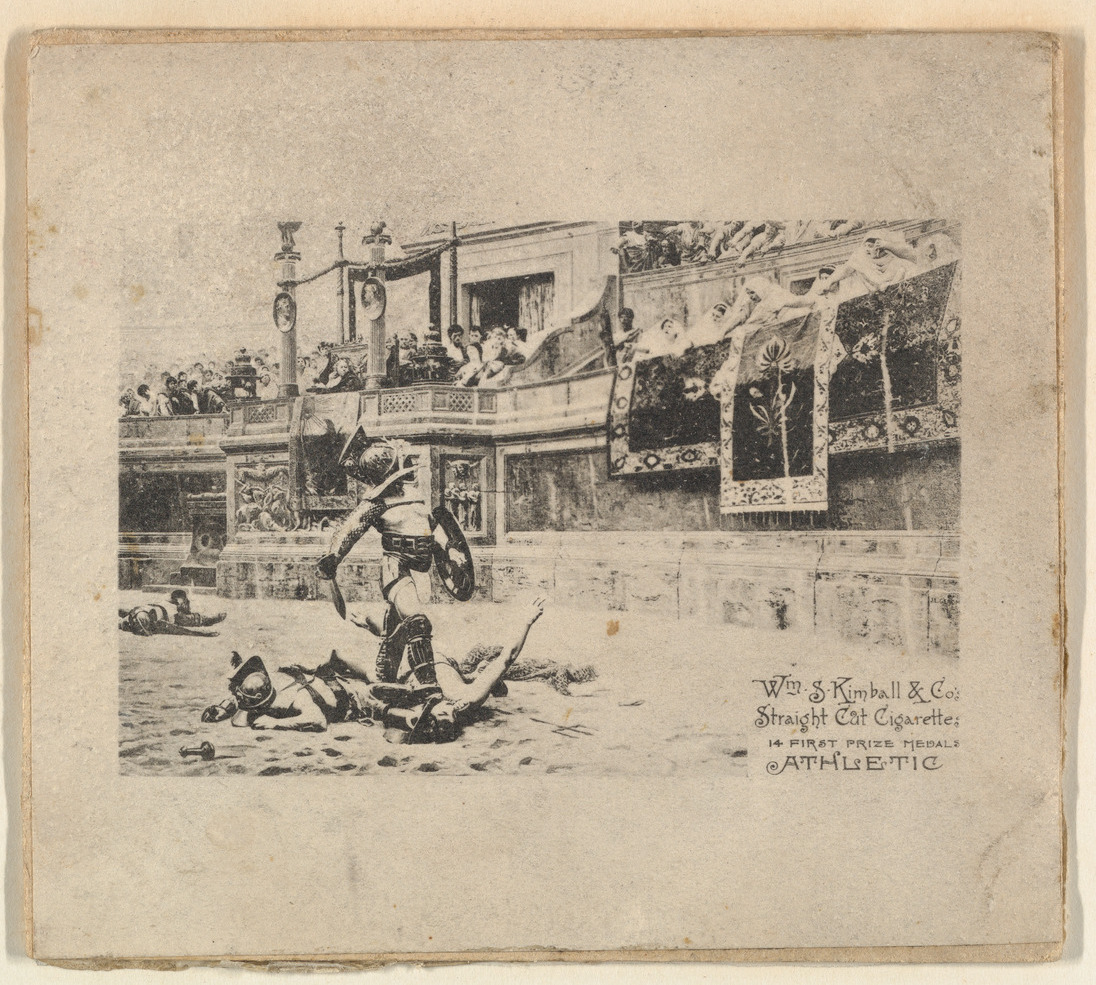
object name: print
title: Athletic, from the Sports and Art Subjects series (N197) issued by Wm. S. Kimball & Co.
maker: william s. kimball & company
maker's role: publisher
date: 1889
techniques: color lithograph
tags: men,spectators